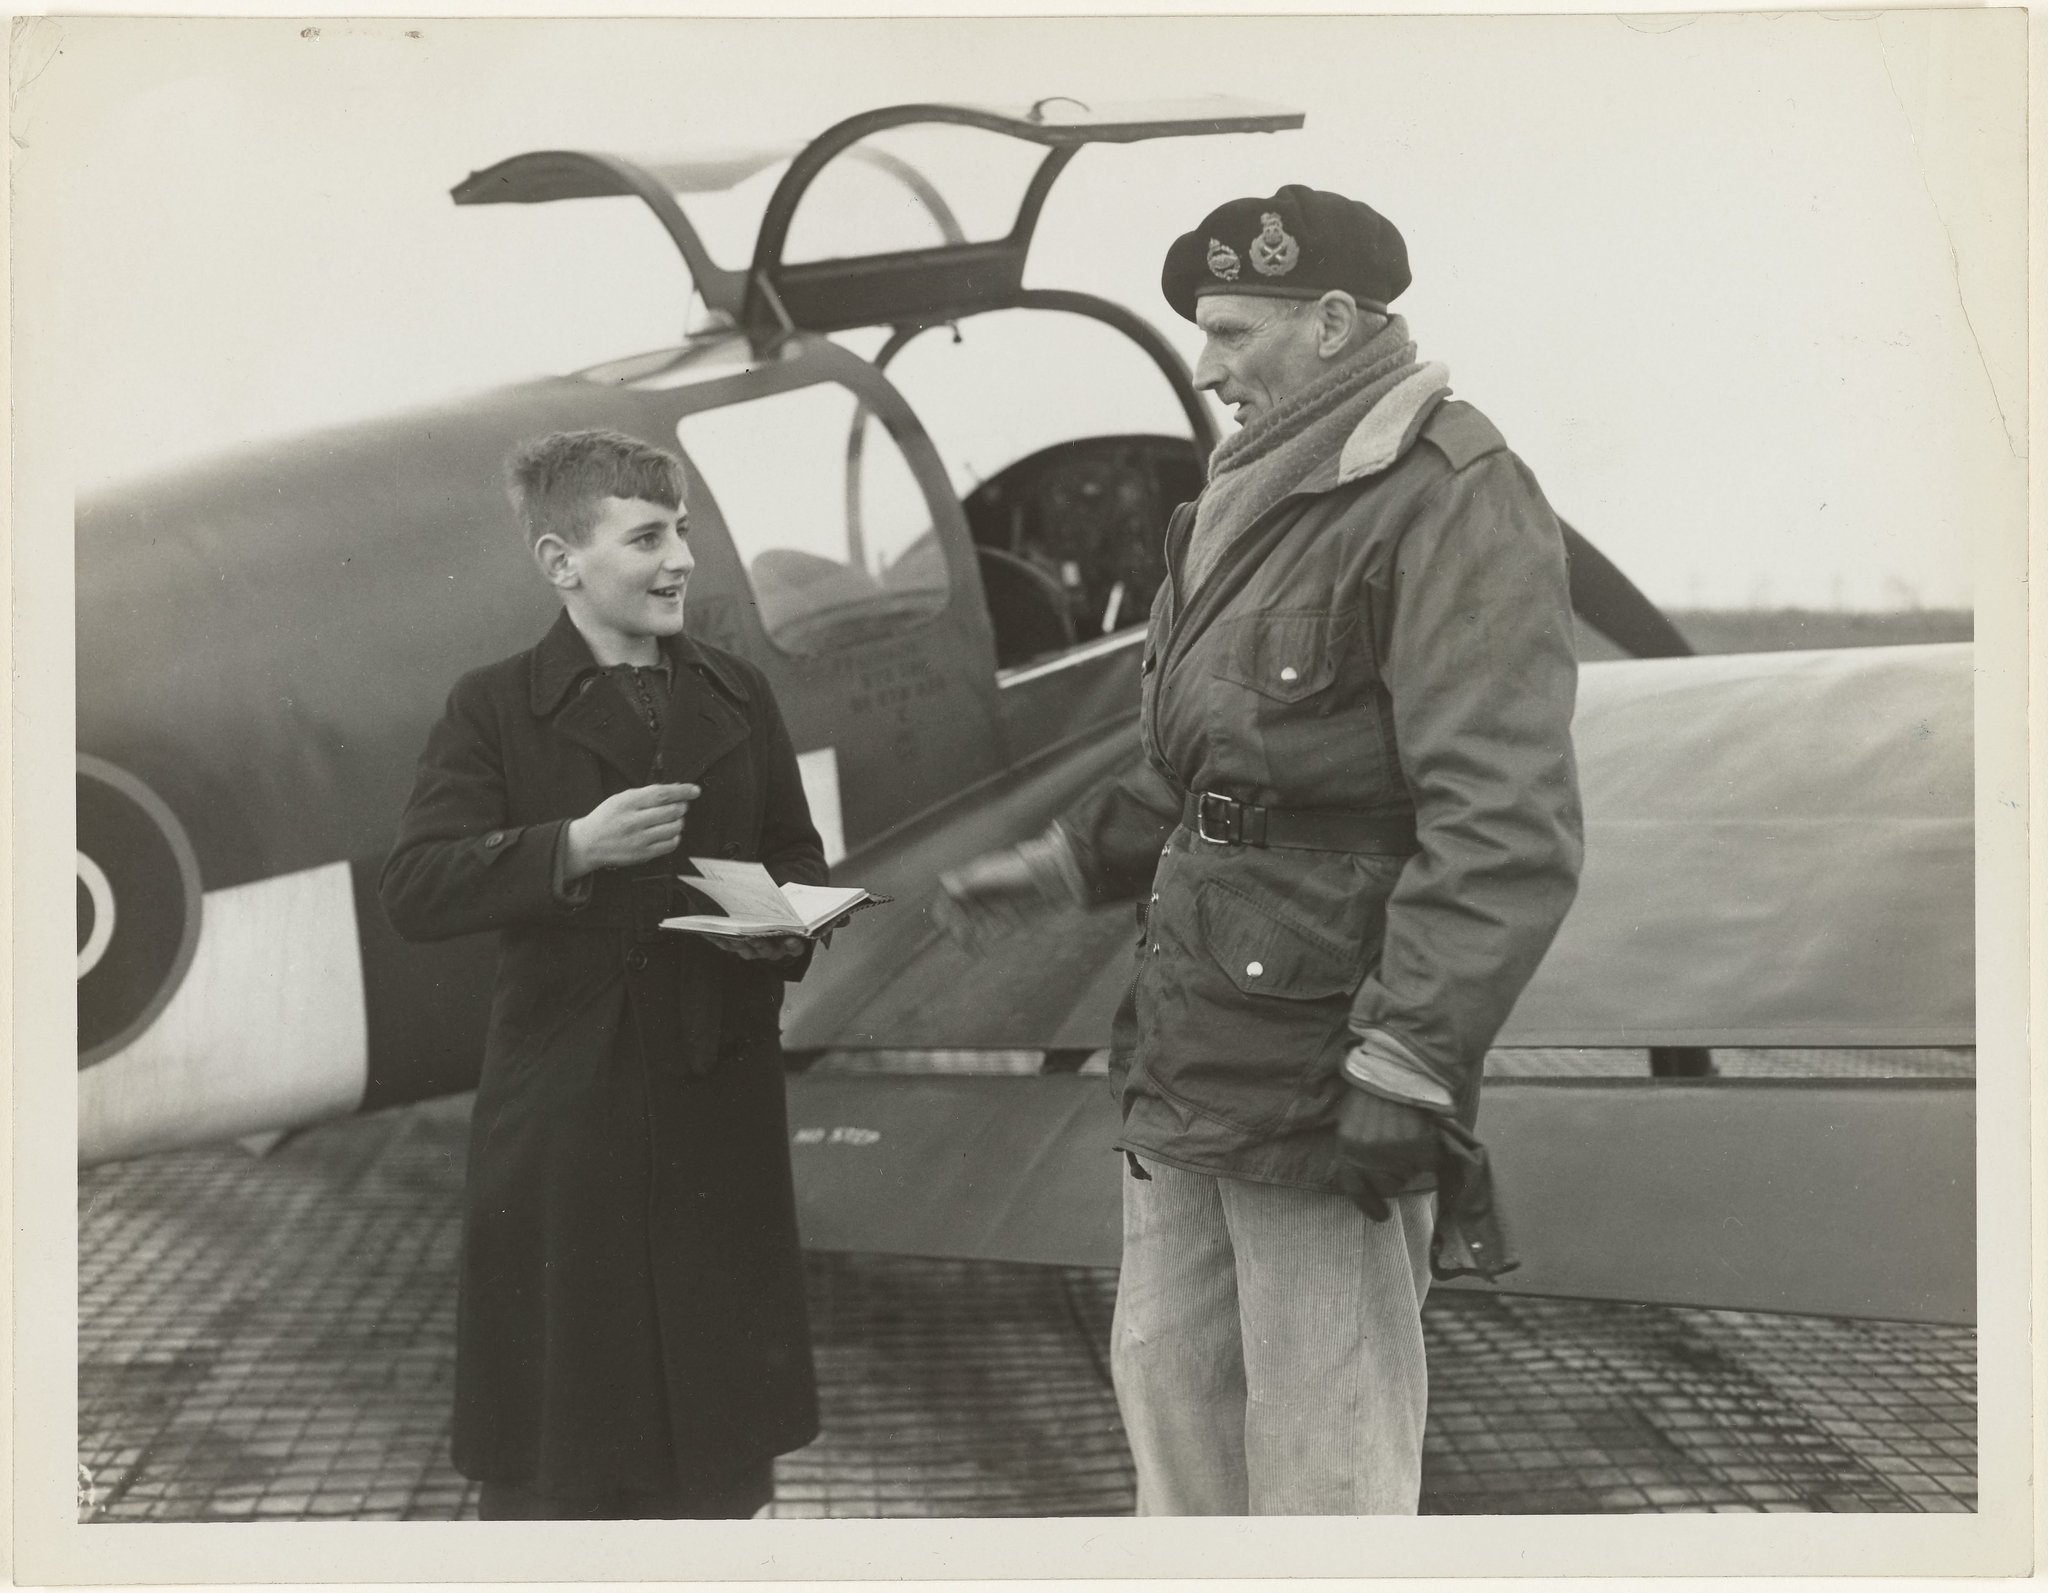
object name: photograph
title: Veldmaarschalk Montgomery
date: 1945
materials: photographic support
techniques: photography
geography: uden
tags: london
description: Veldmaarschalk Montgomery geeft een handtekening aan een Nederlandse jongen tijdens zijn bezoek aan generaal Crear bij het 1st Canadian Army Headquarters om een aanval op de Siegfried Linie te bespreken.